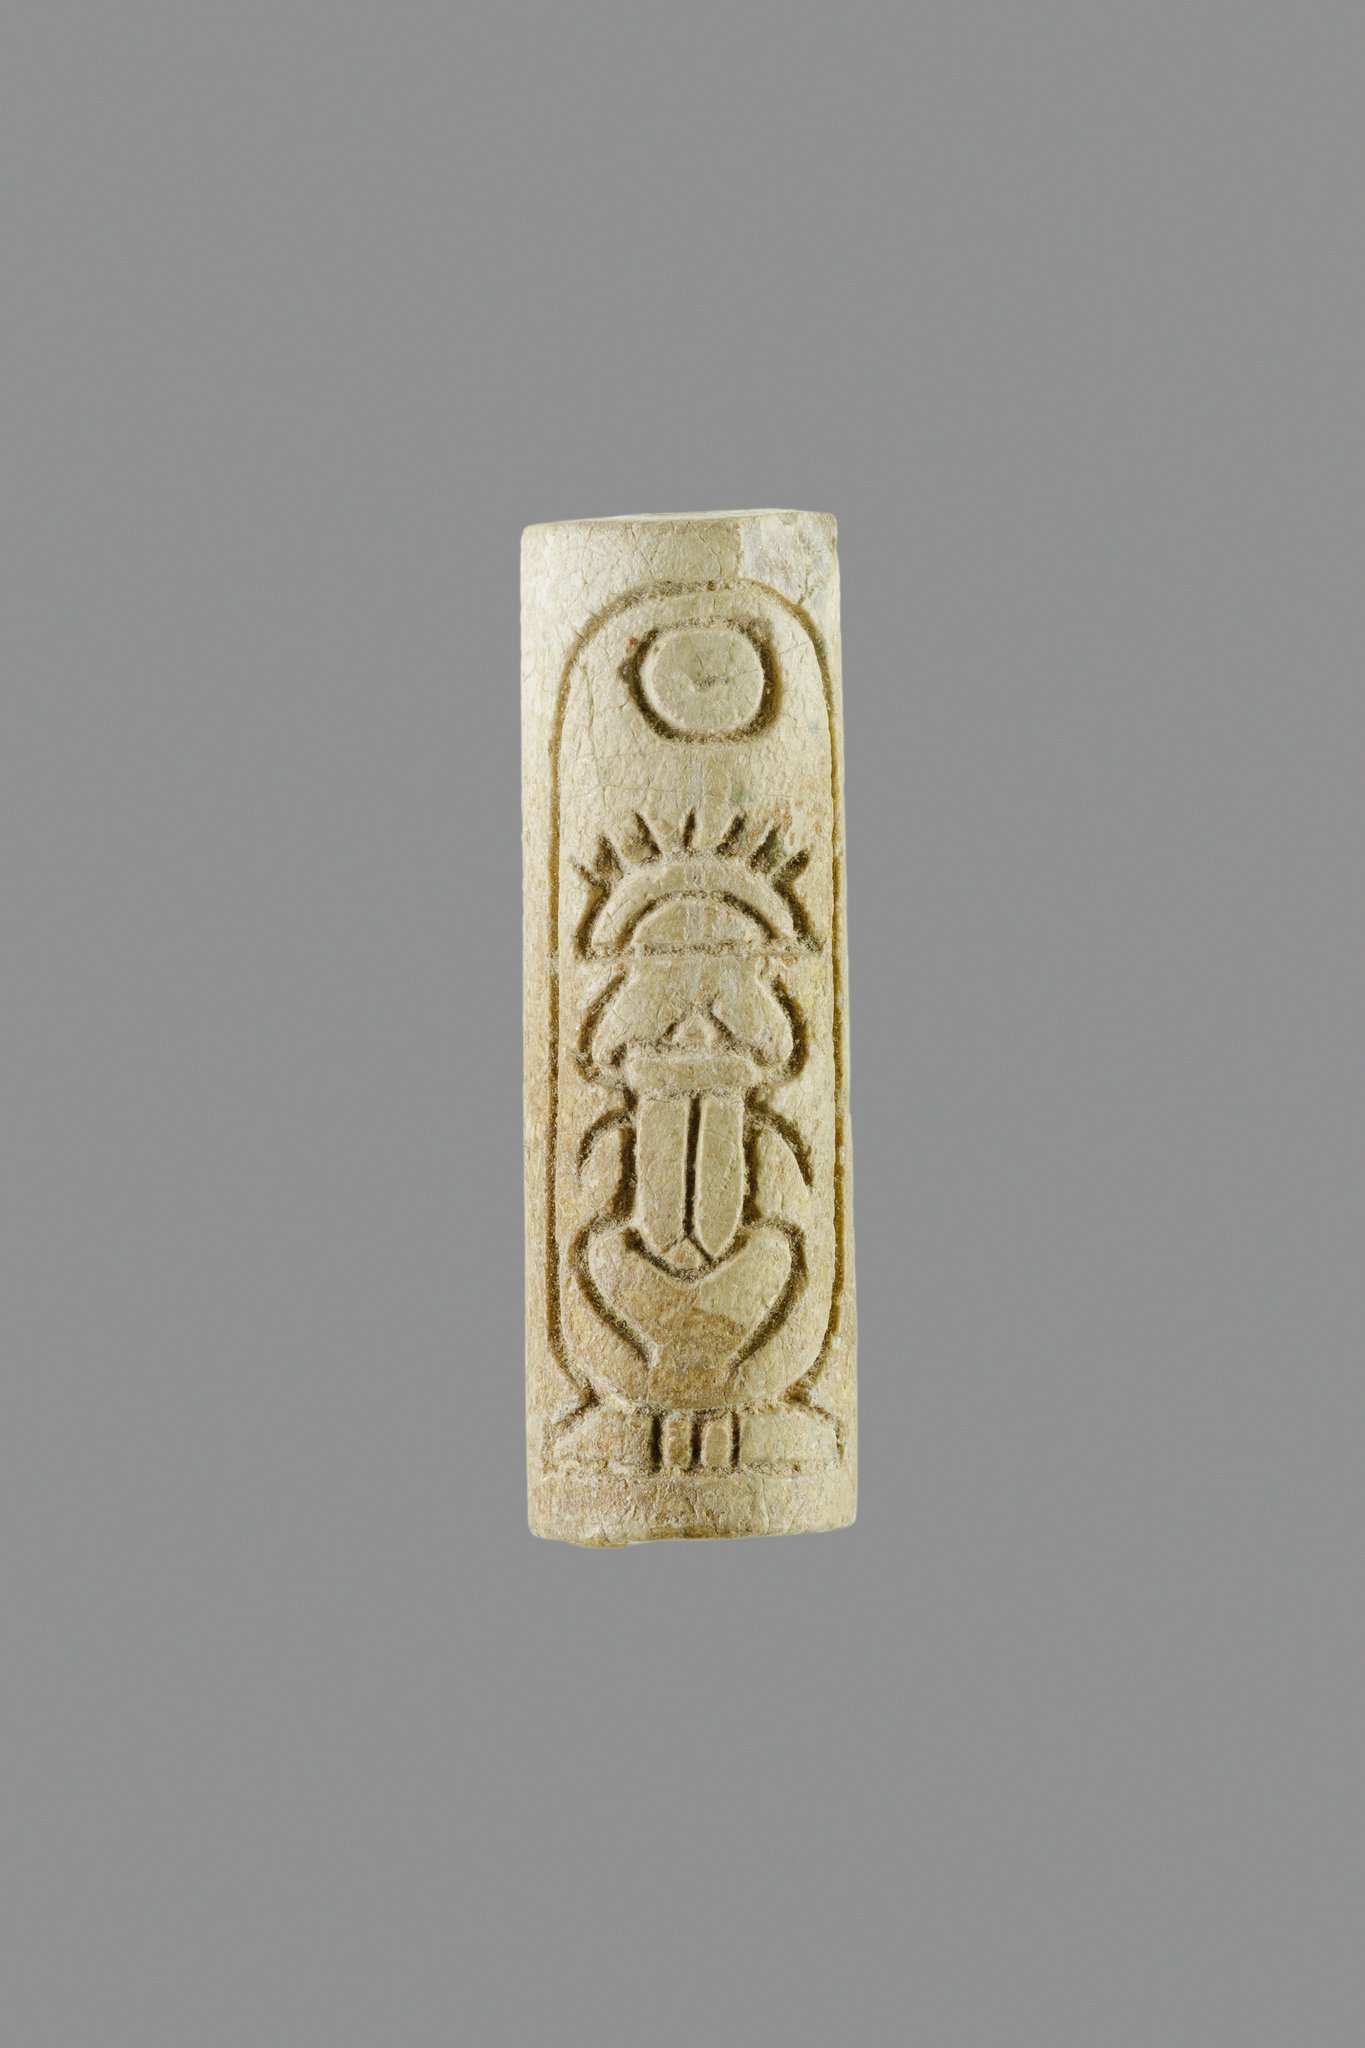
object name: cylinder seal, hieroglyph, cartouche, senwosret ii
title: Cylinder seal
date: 1961-1917 BCE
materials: stone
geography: egypt